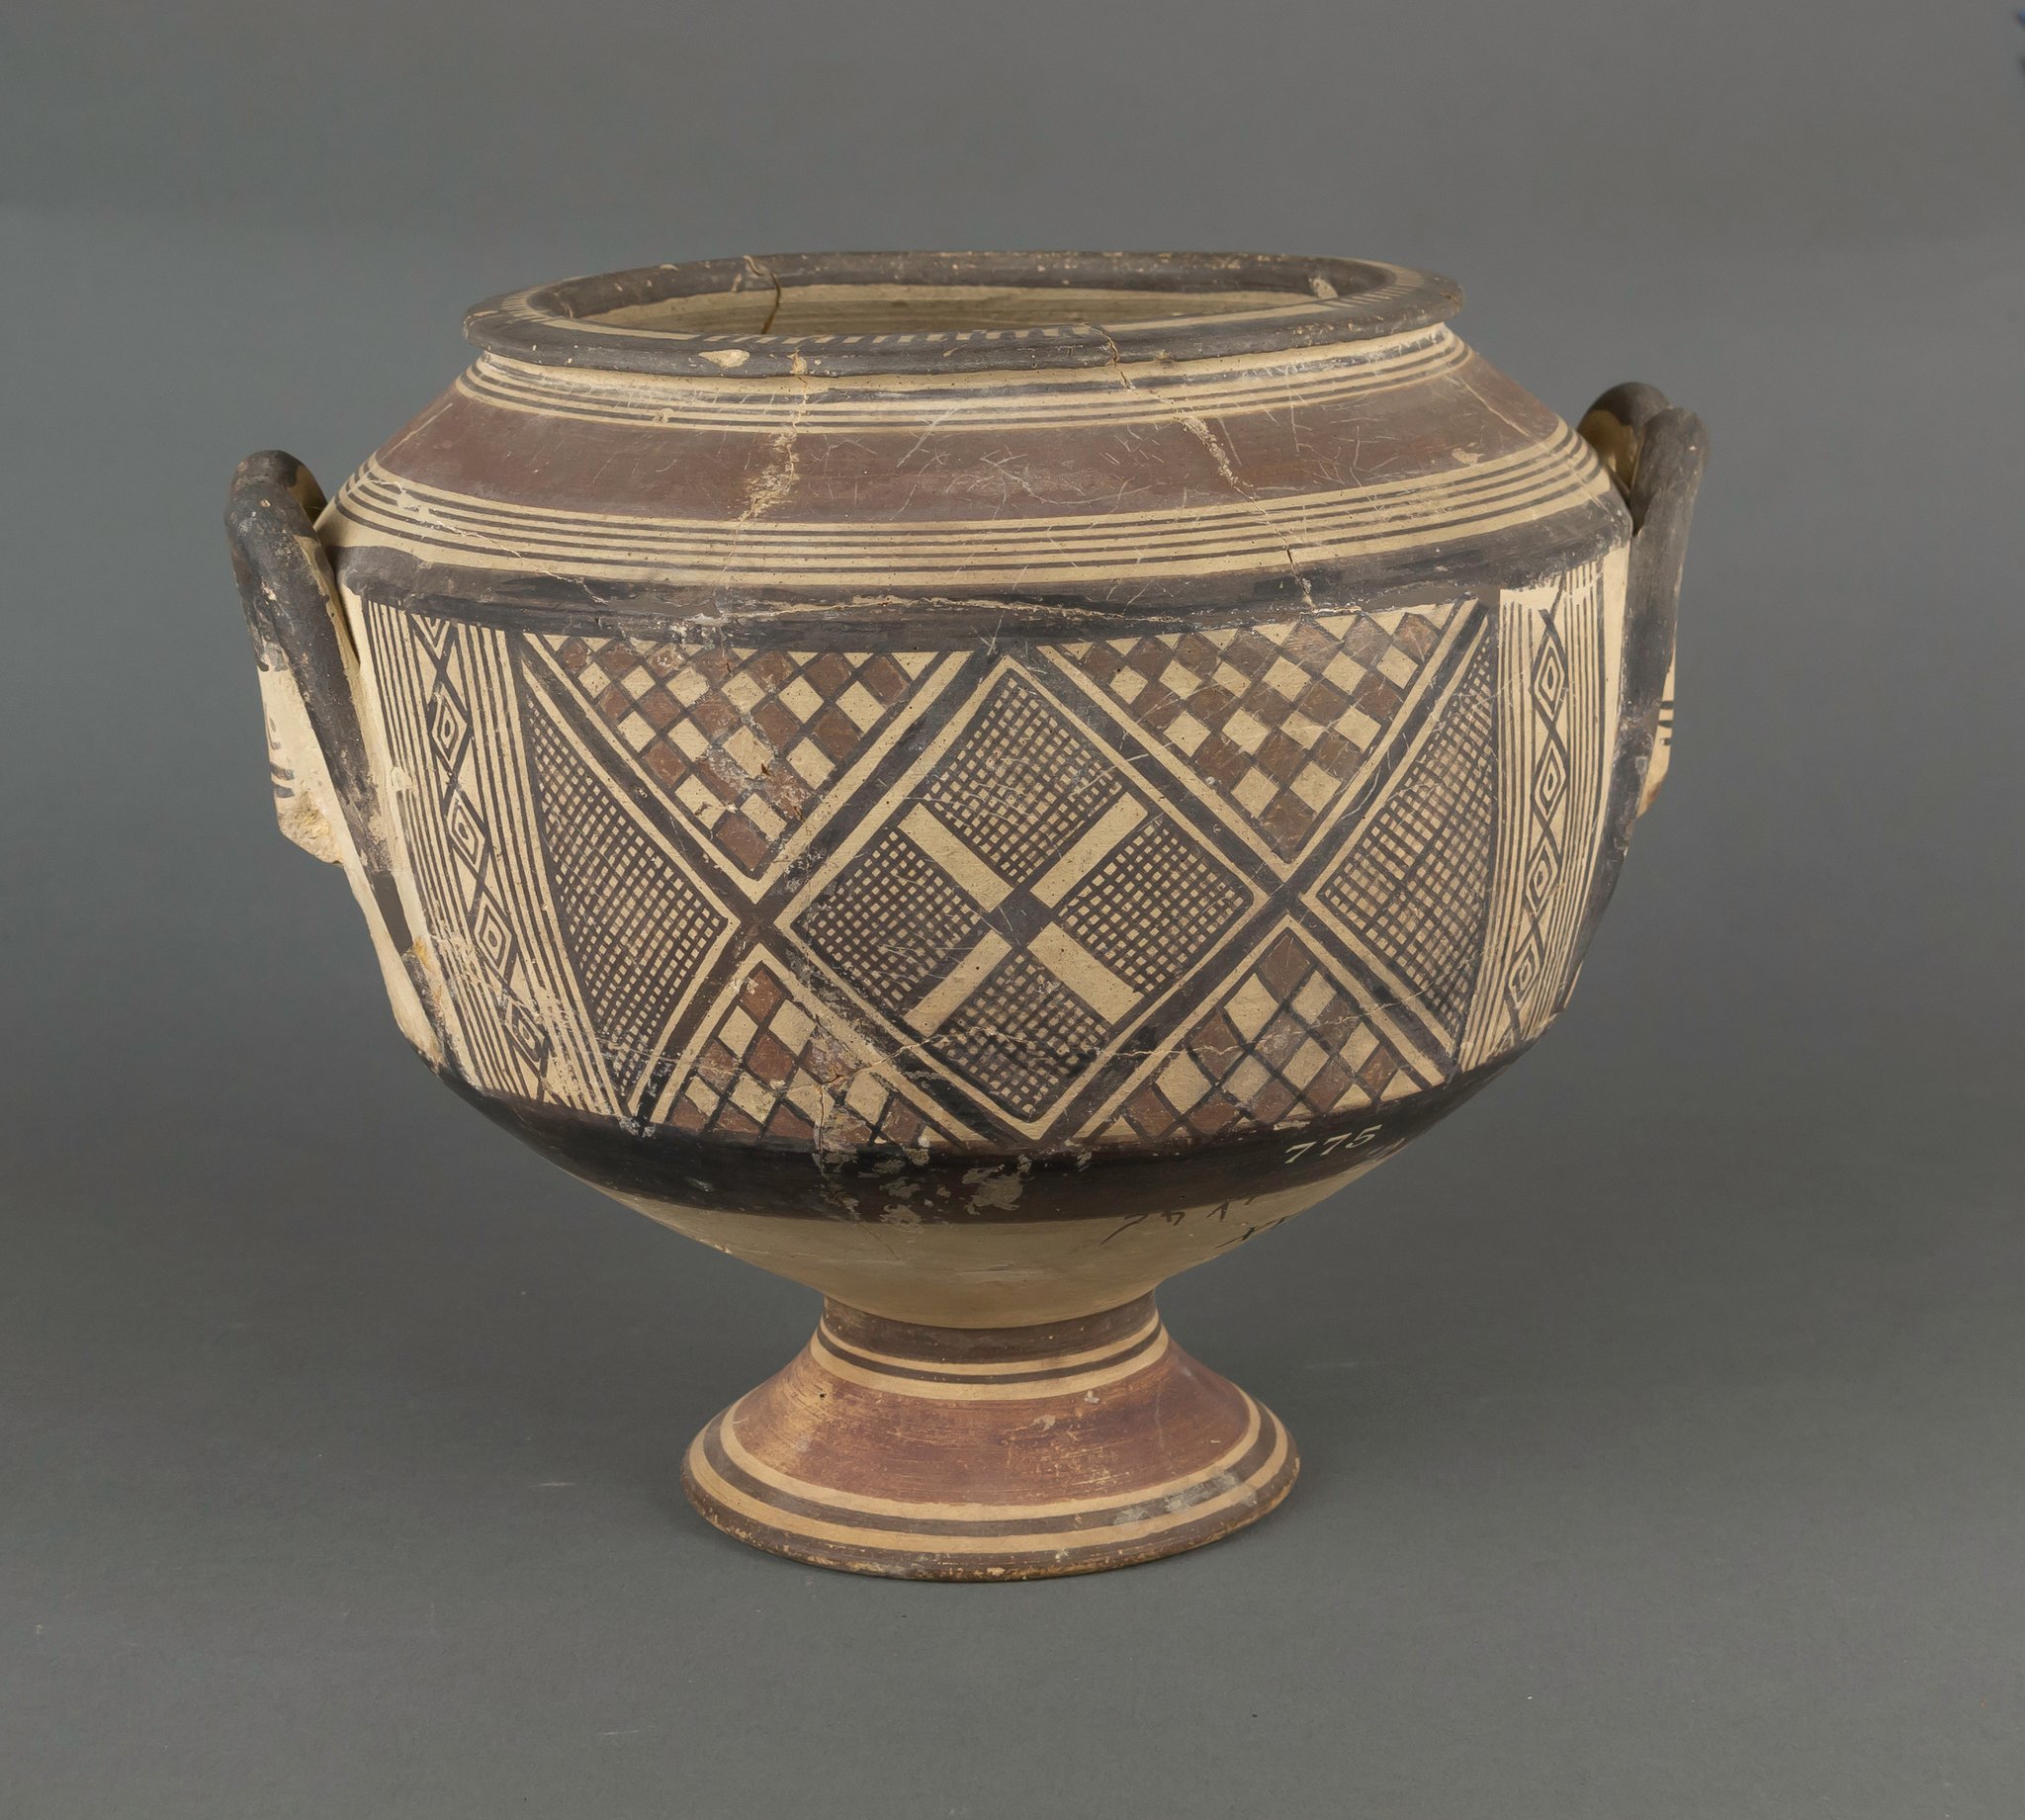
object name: amphora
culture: cypriot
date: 700-601 BCE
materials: terracotta